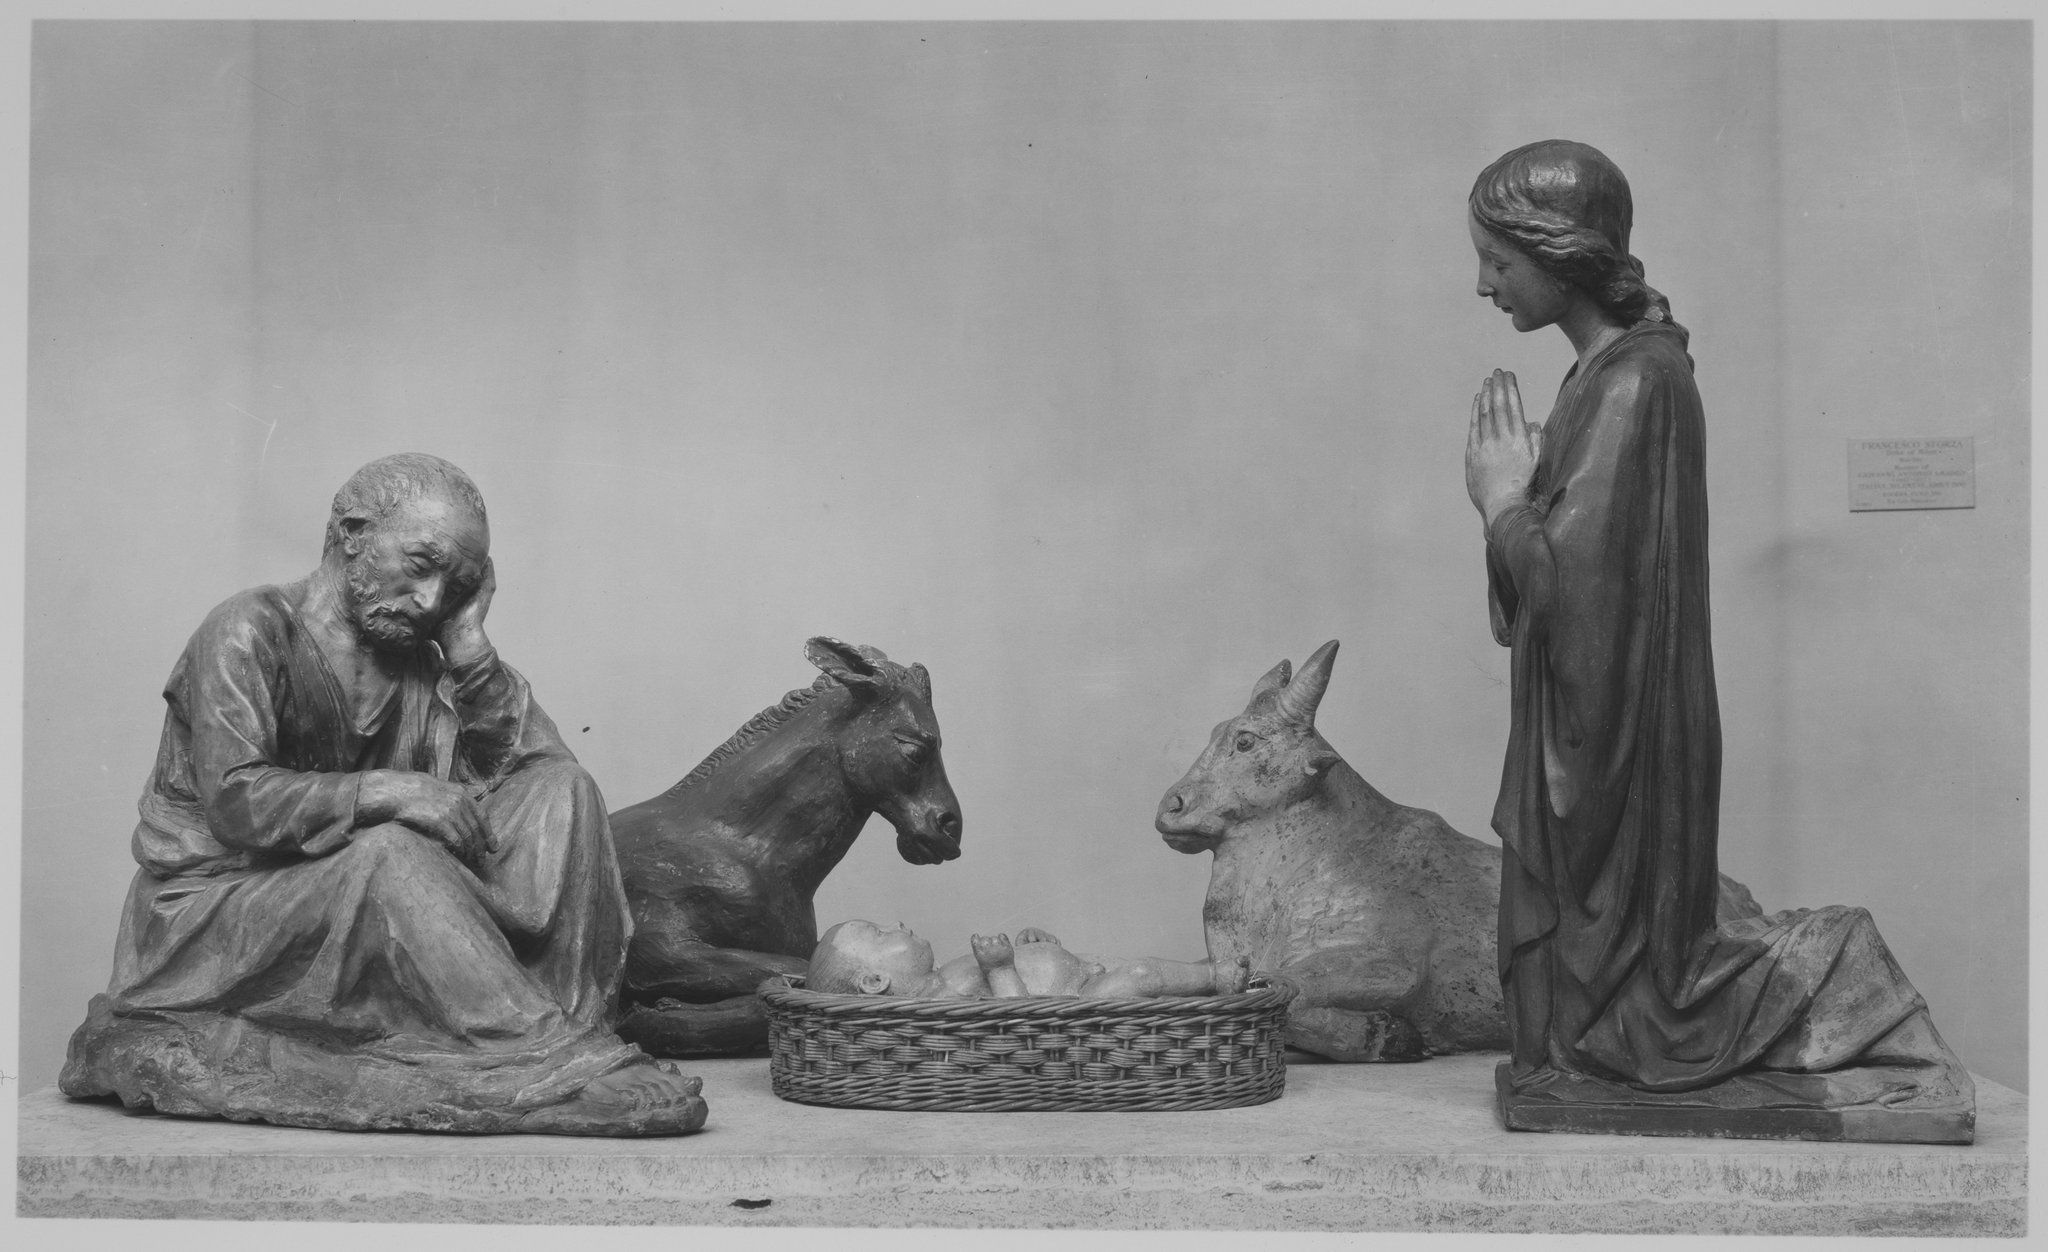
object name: crèche figure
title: Nativity (five figures forming a presepio)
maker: antonio rossellino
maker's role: artist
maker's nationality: italian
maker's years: 1427-1479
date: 1401-1500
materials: terracotta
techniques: painting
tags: animals,holy family,jesus,nativity,birth